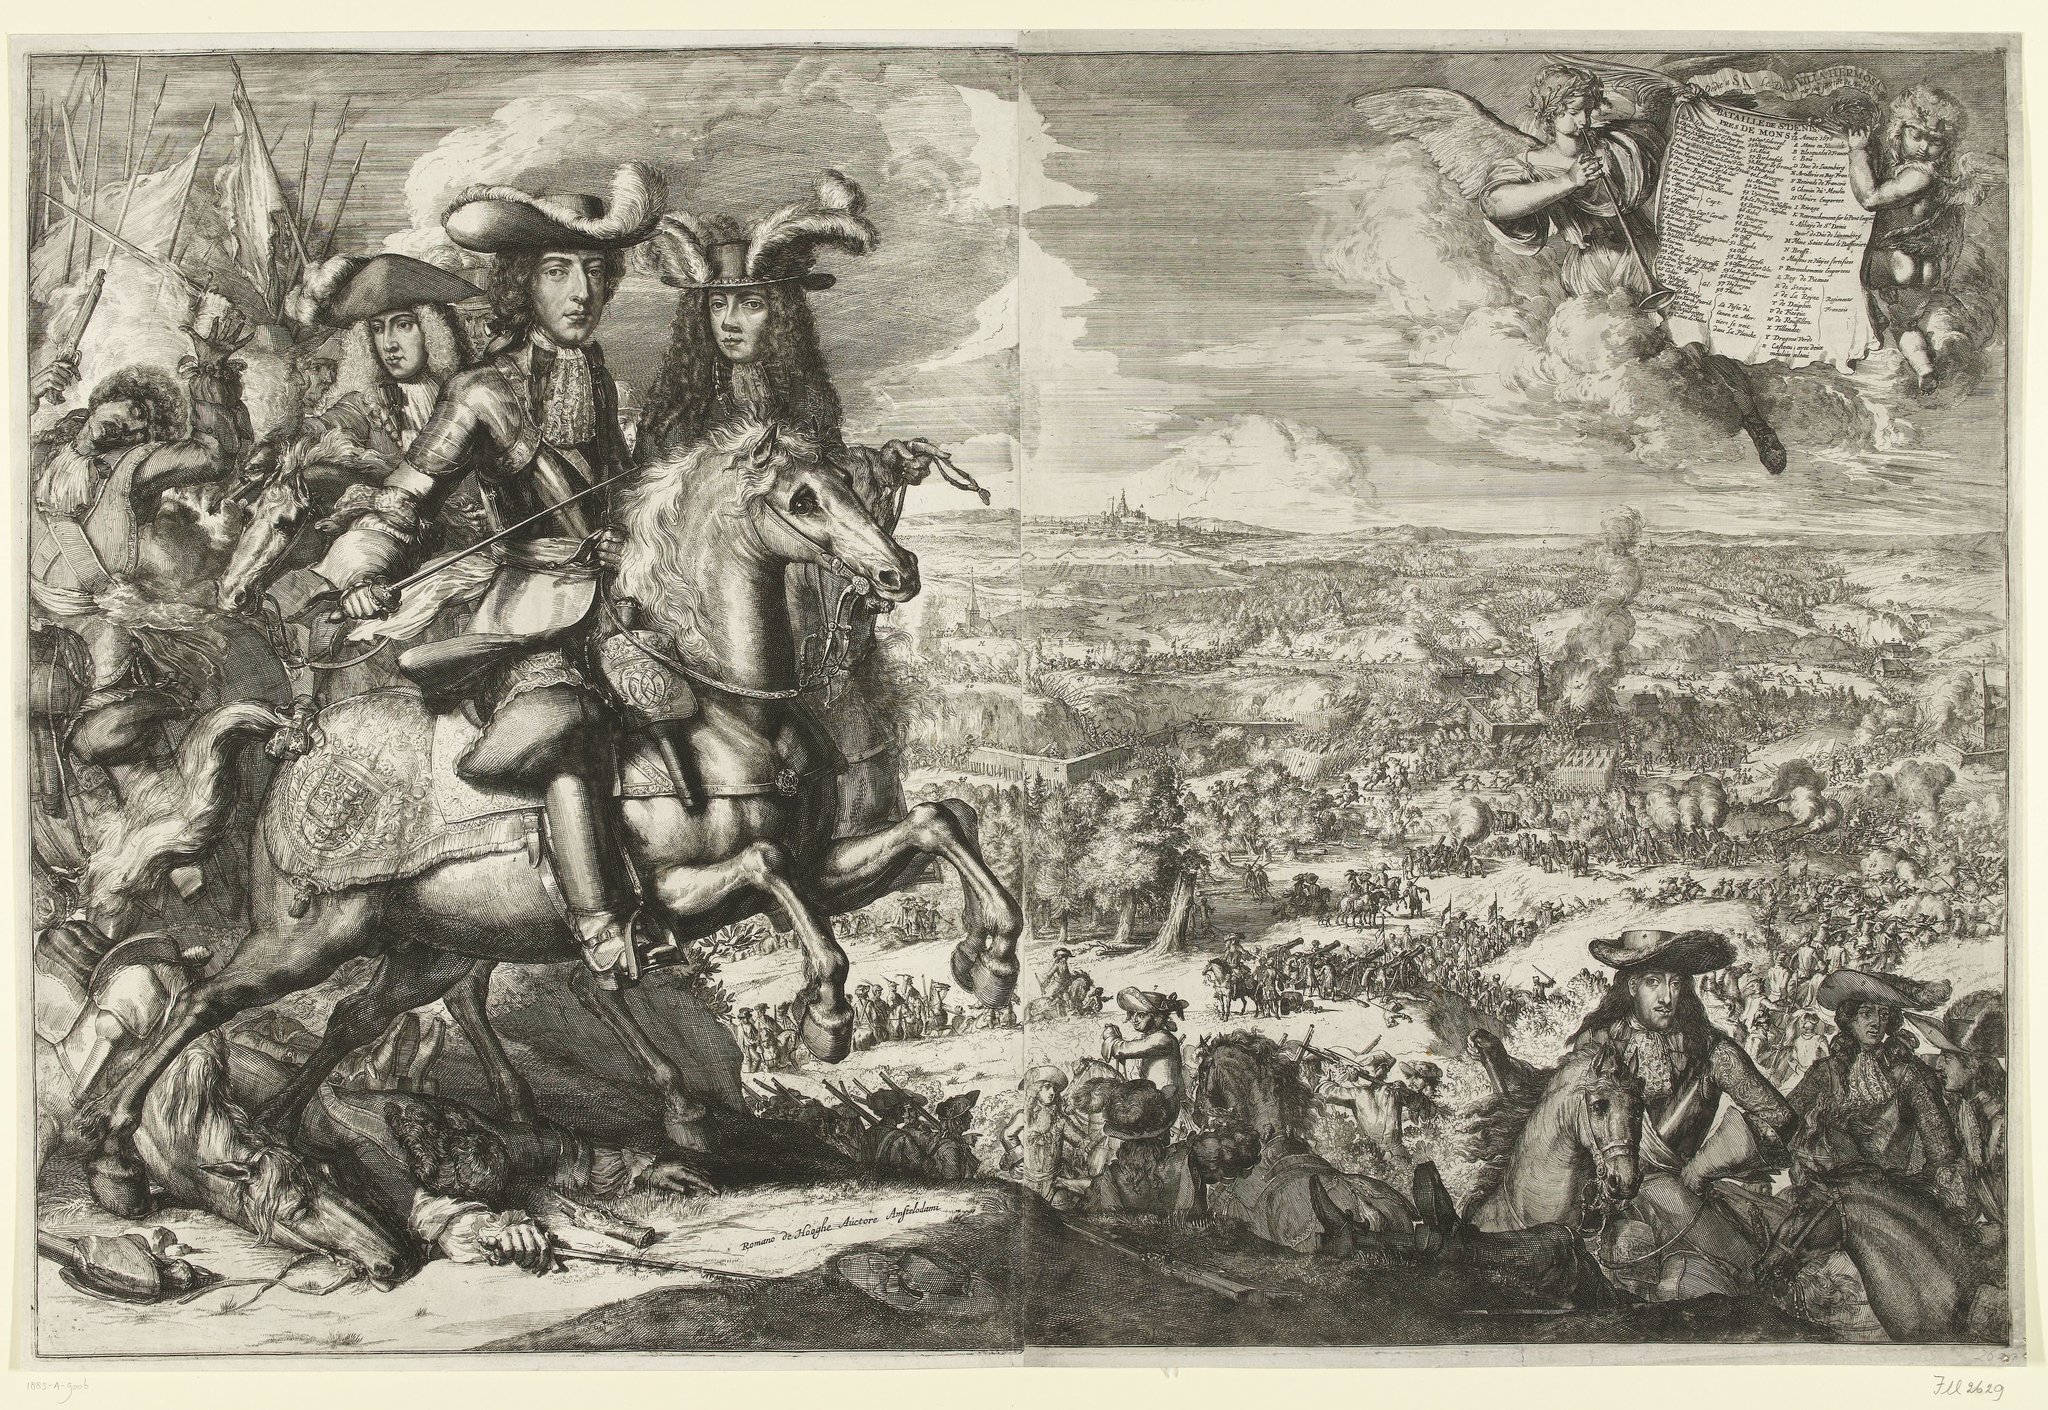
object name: print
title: Slag bij St. Denis, 1678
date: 1678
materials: paper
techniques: etching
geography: amsterdam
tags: the hague, william iii (prince of orange and king of england, scotland, and ireland), politician, carlos de aragón de gurrea (9th duke of villahermosa), rotterdam, london, equestrian state-portrait, battle, fighting in general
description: Grote voorstelling van slag bij St. Denis op 14 augustus 1678. Links op de voorgrond prins Willem III naast de hertog van Monmouth te paard met andere leden van zijn staf. Gezicht op het slagveld, rechtsonder de hertog van Villahermosa. In de lucht vliegt Faam blazend op haar bazuin, in de hand een cartouche met de legenda's 1-58 en A-Z in het Frans.